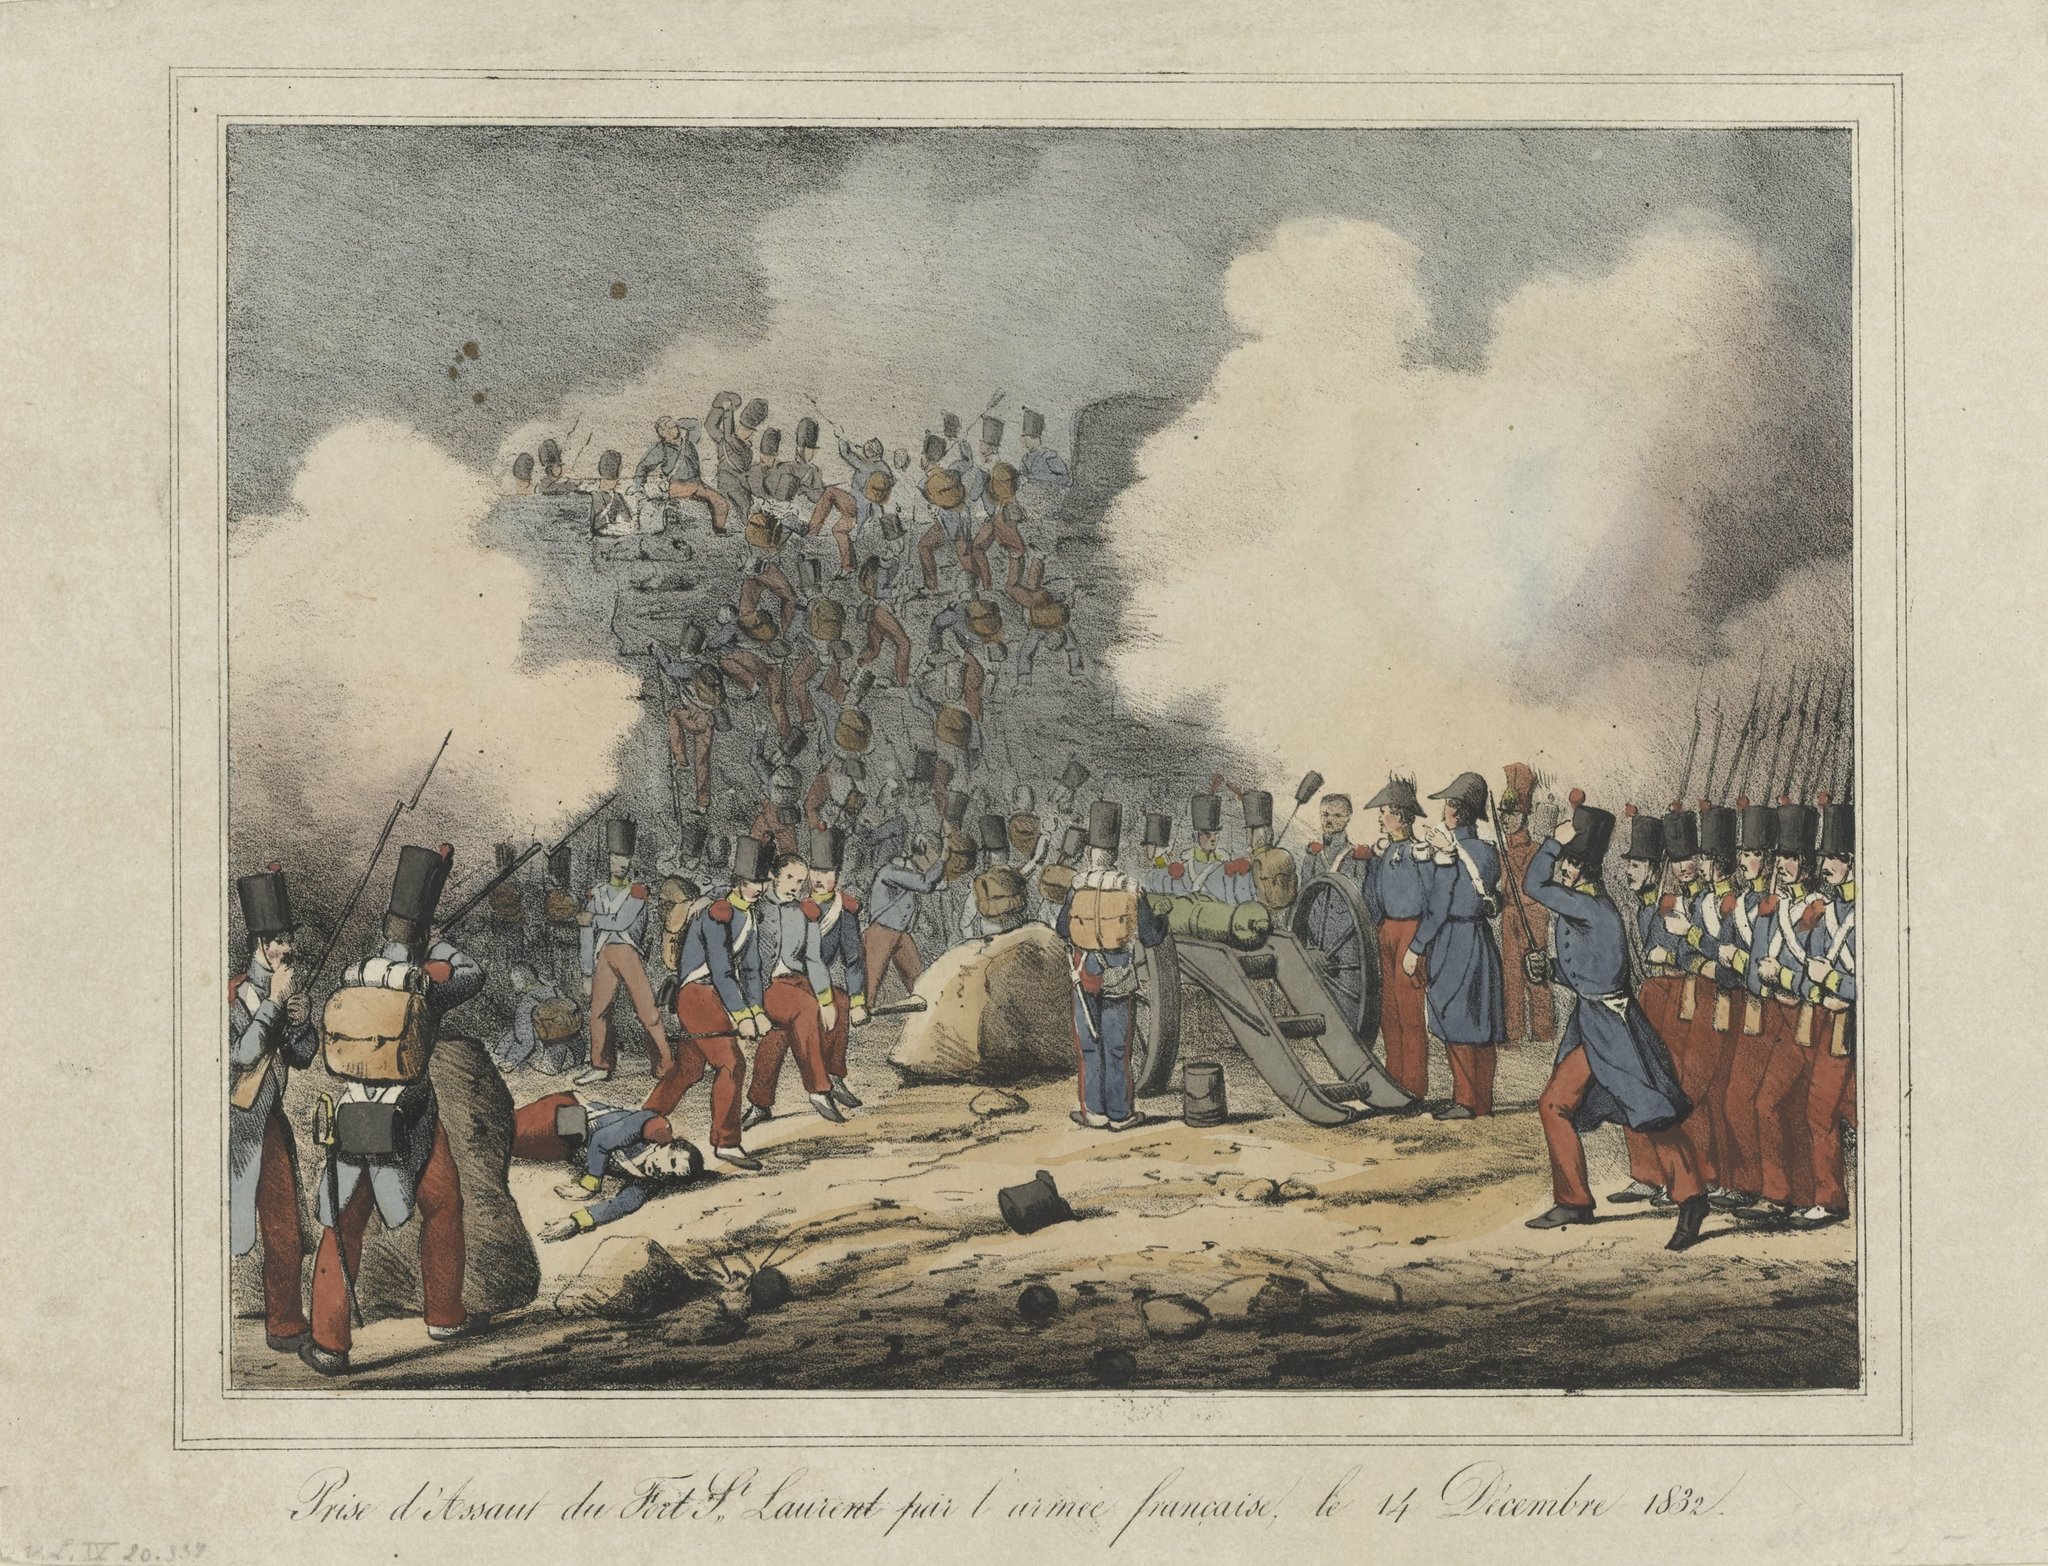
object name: print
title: Prise d'Assaut du Fort St. Laurent par l'armée française, le 14 Décembre 1832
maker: Anonymous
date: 1832-1833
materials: paper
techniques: hand coloring, lithograph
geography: france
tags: assault ~ siege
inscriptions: collector's mark: Lugt 2228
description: Verovering van de lunet van Saint-Laurent (Sint Laurens) door het Franse leger op 13 december, tijdens het beleg van de Citadel van Antwerpen, december 1832.